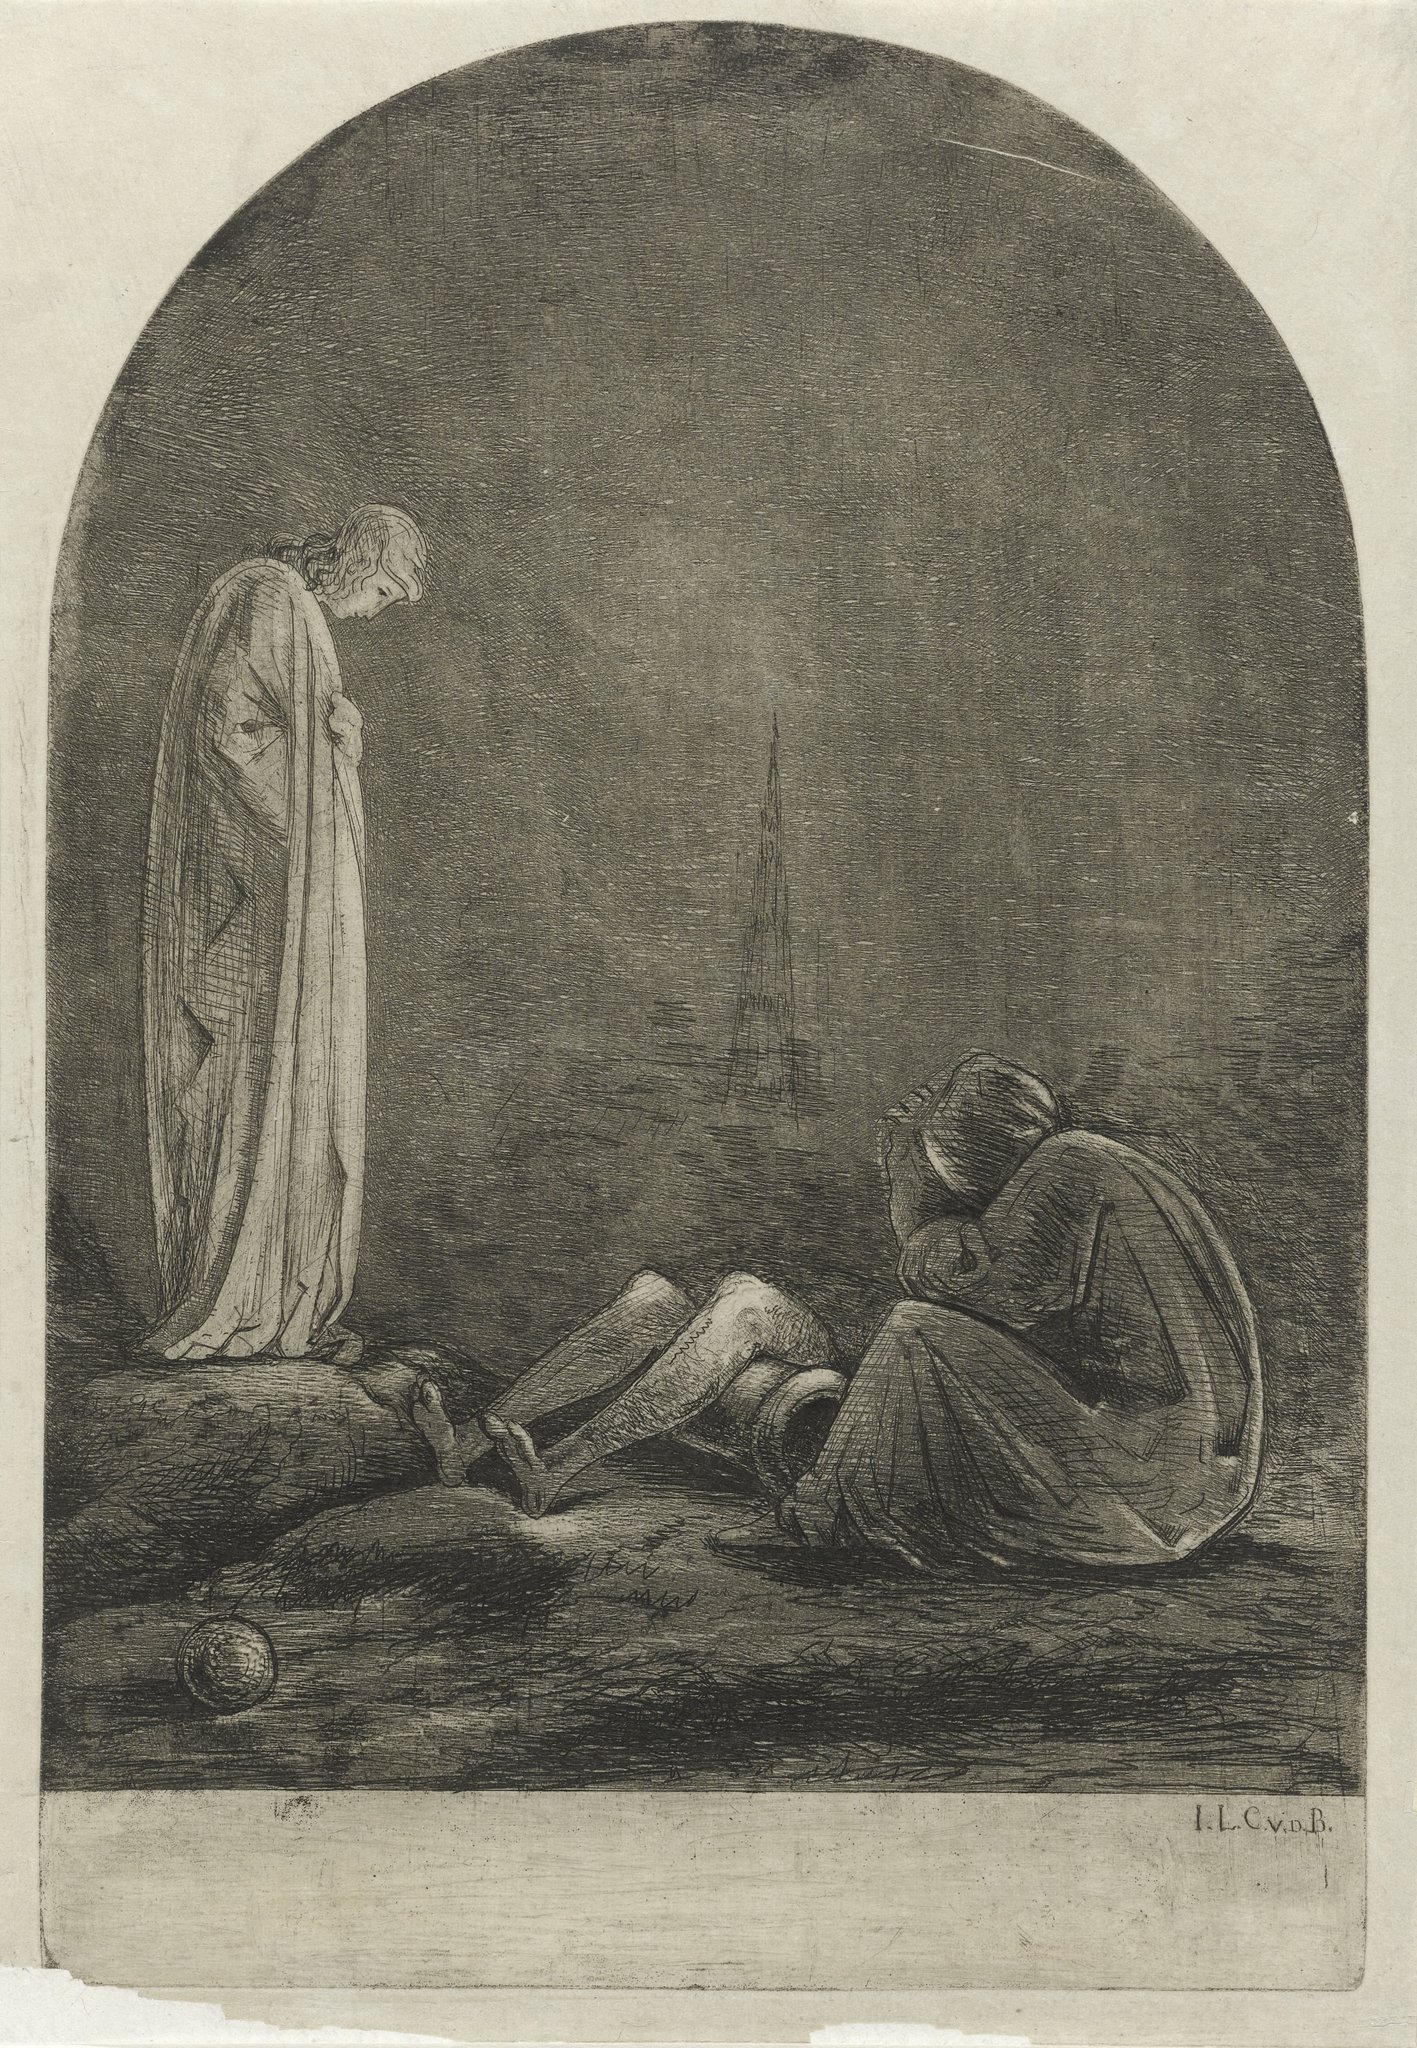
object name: print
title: Gedachte op de overgave van de Citadel van Antwerpen, 1832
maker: jonkheer isaac lambertus cremer van den berch van heemstede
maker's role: print maker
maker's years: 1811-1879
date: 1832-1833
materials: paper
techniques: drypoint, etching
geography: leiden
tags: mourning the dead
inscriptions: collector's mark: Lugt 2228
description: Allegorie op de overgave van de Citadel van Antwerpen, 23 december 1832. Een geheel gesluierde figuur zit treurend bij het lichaam van een mens gesneuveld in de strijd. Links ziet een staande figuur toe met gebogen hoofd. De benen van het slachtoffer liggen gebogen over de loop van een kanon, links een granaat. Op de achtergrond in de schaduwen een kerktoren.